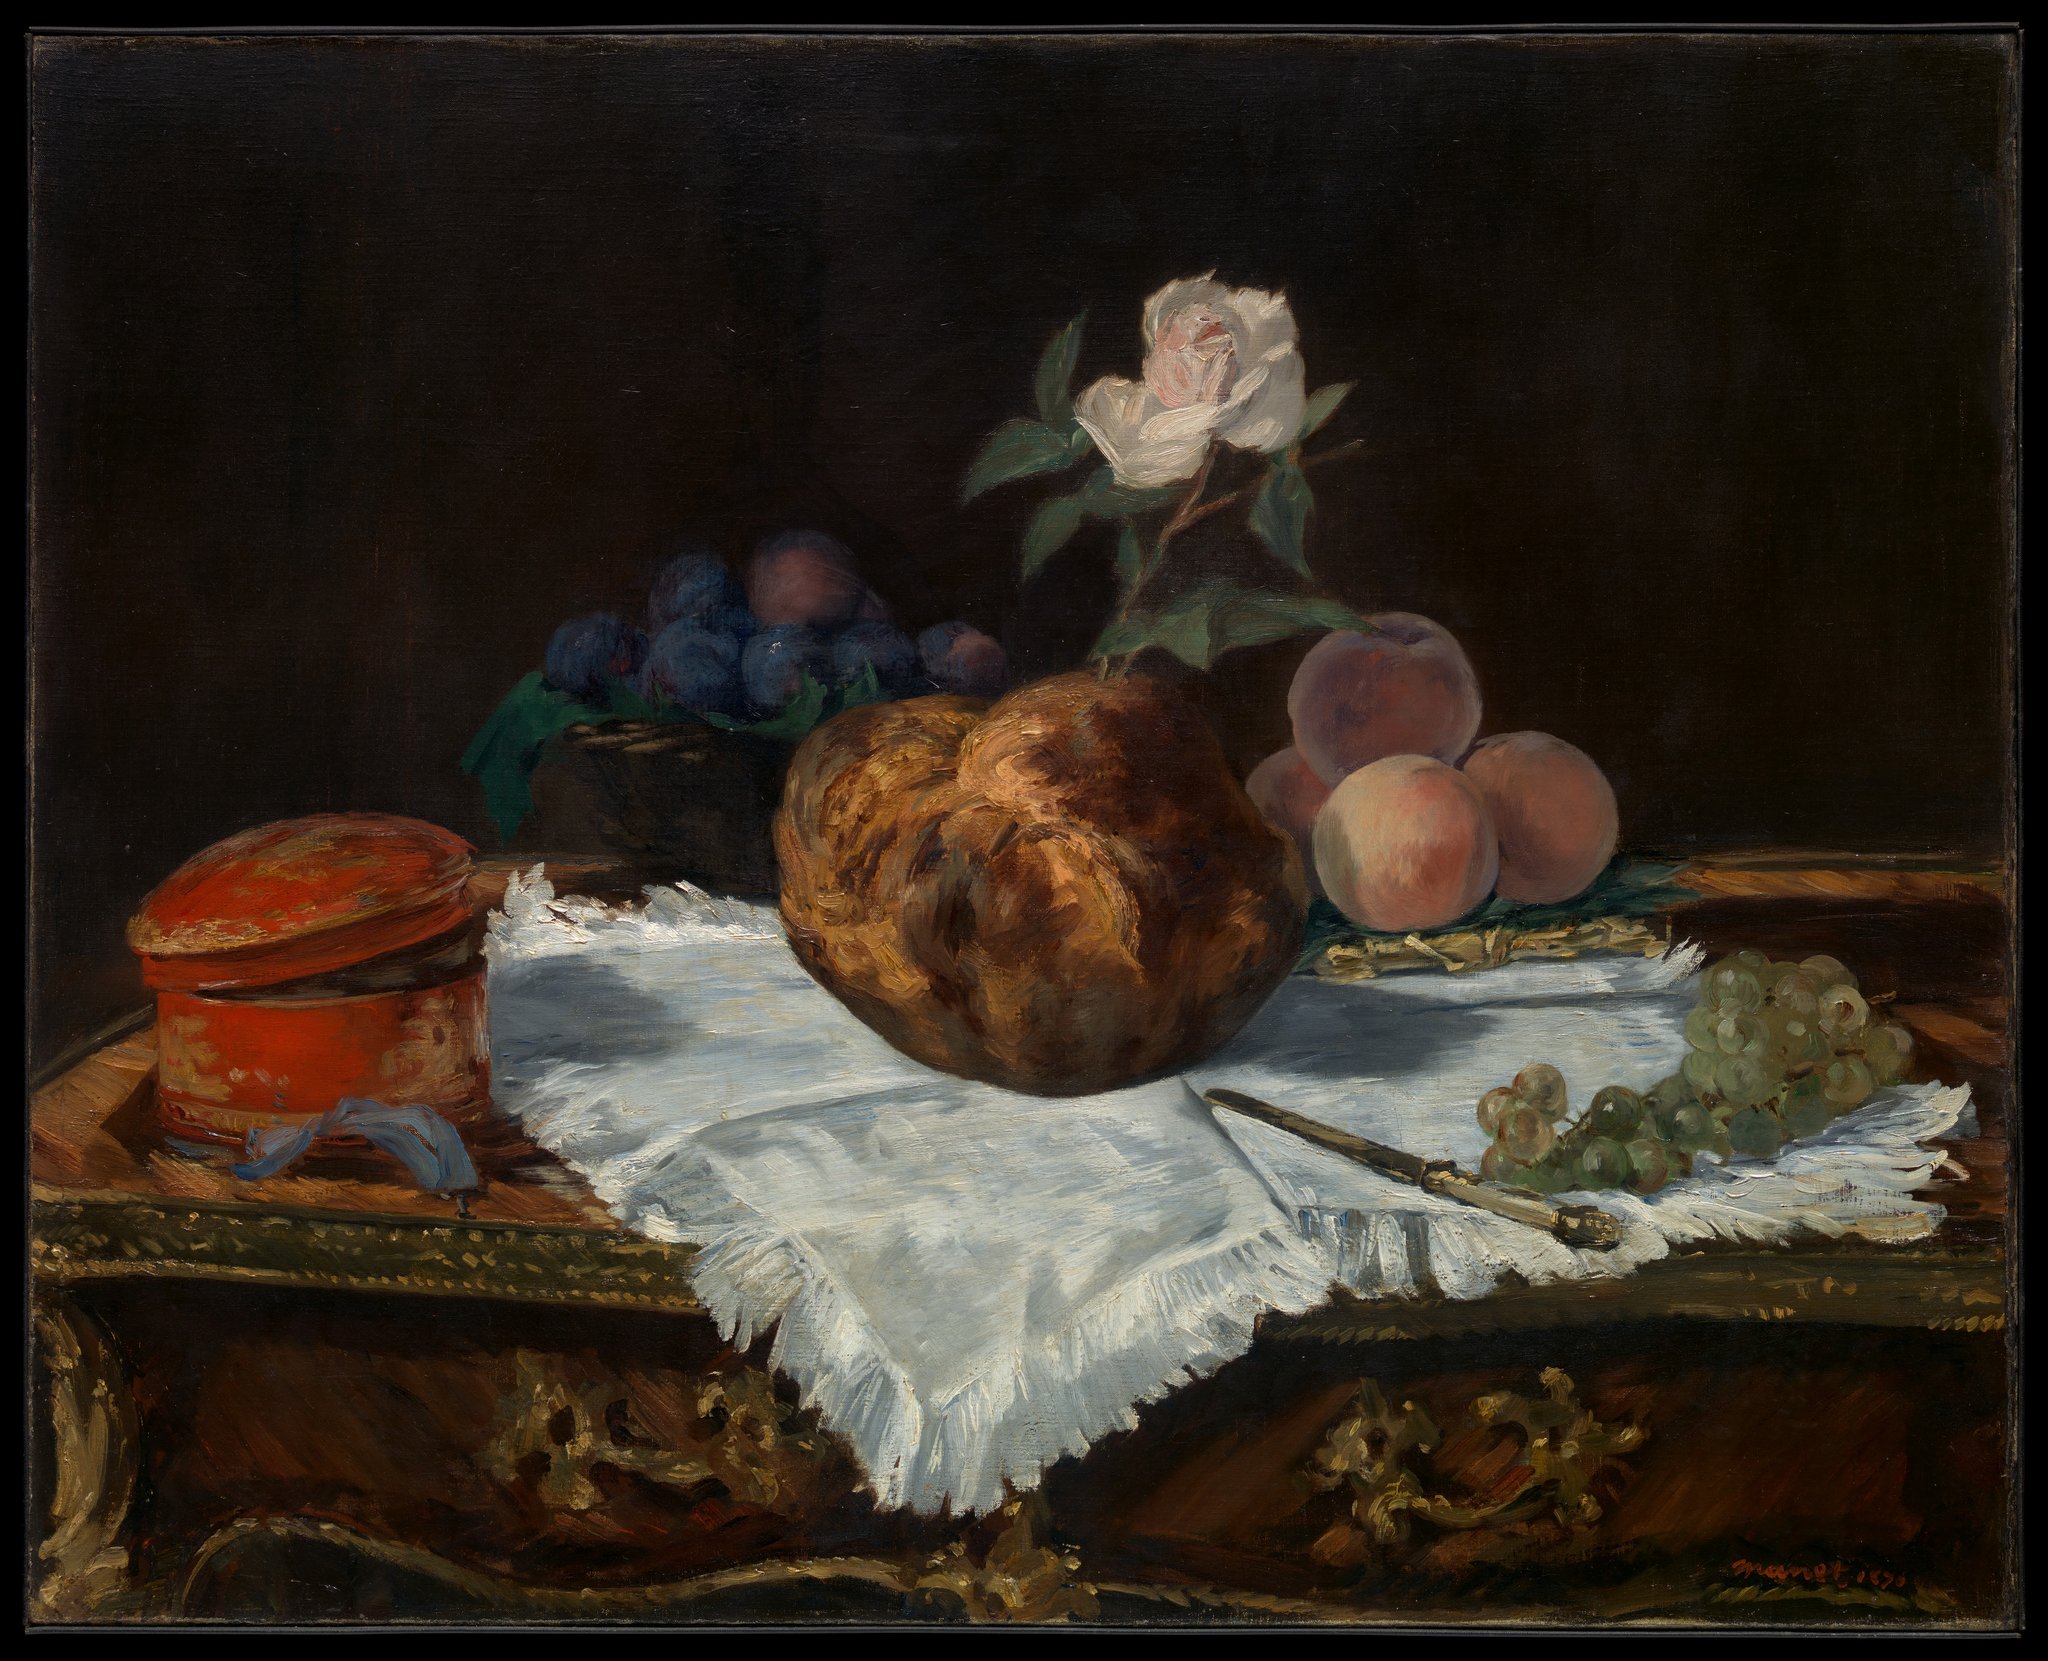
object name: painting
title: The Brioche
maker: édouard manet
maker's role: artist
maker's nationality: french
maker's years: 1832-1883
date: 1870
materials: canvas, oil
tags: bread,grapes,peaches,flowers,still life